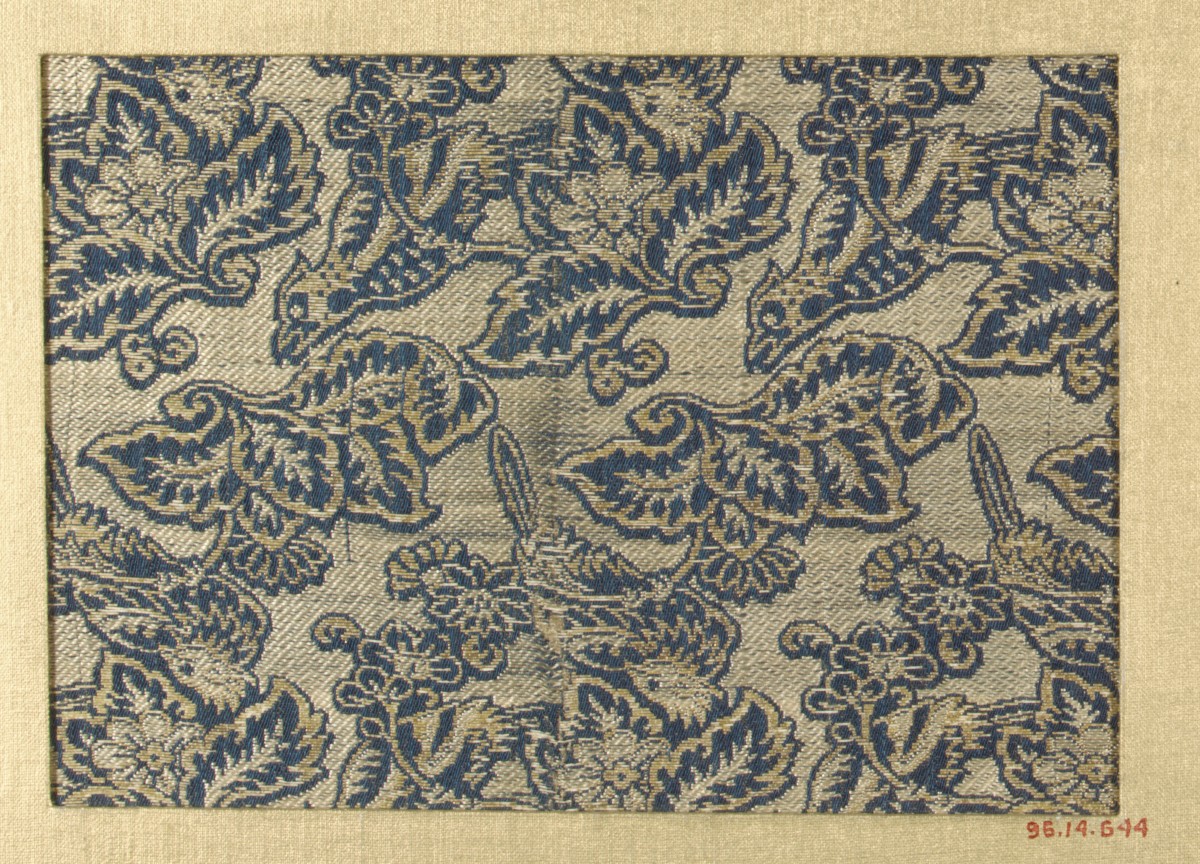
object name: piece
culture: japanese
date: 1701-1900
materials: silk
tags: leaves